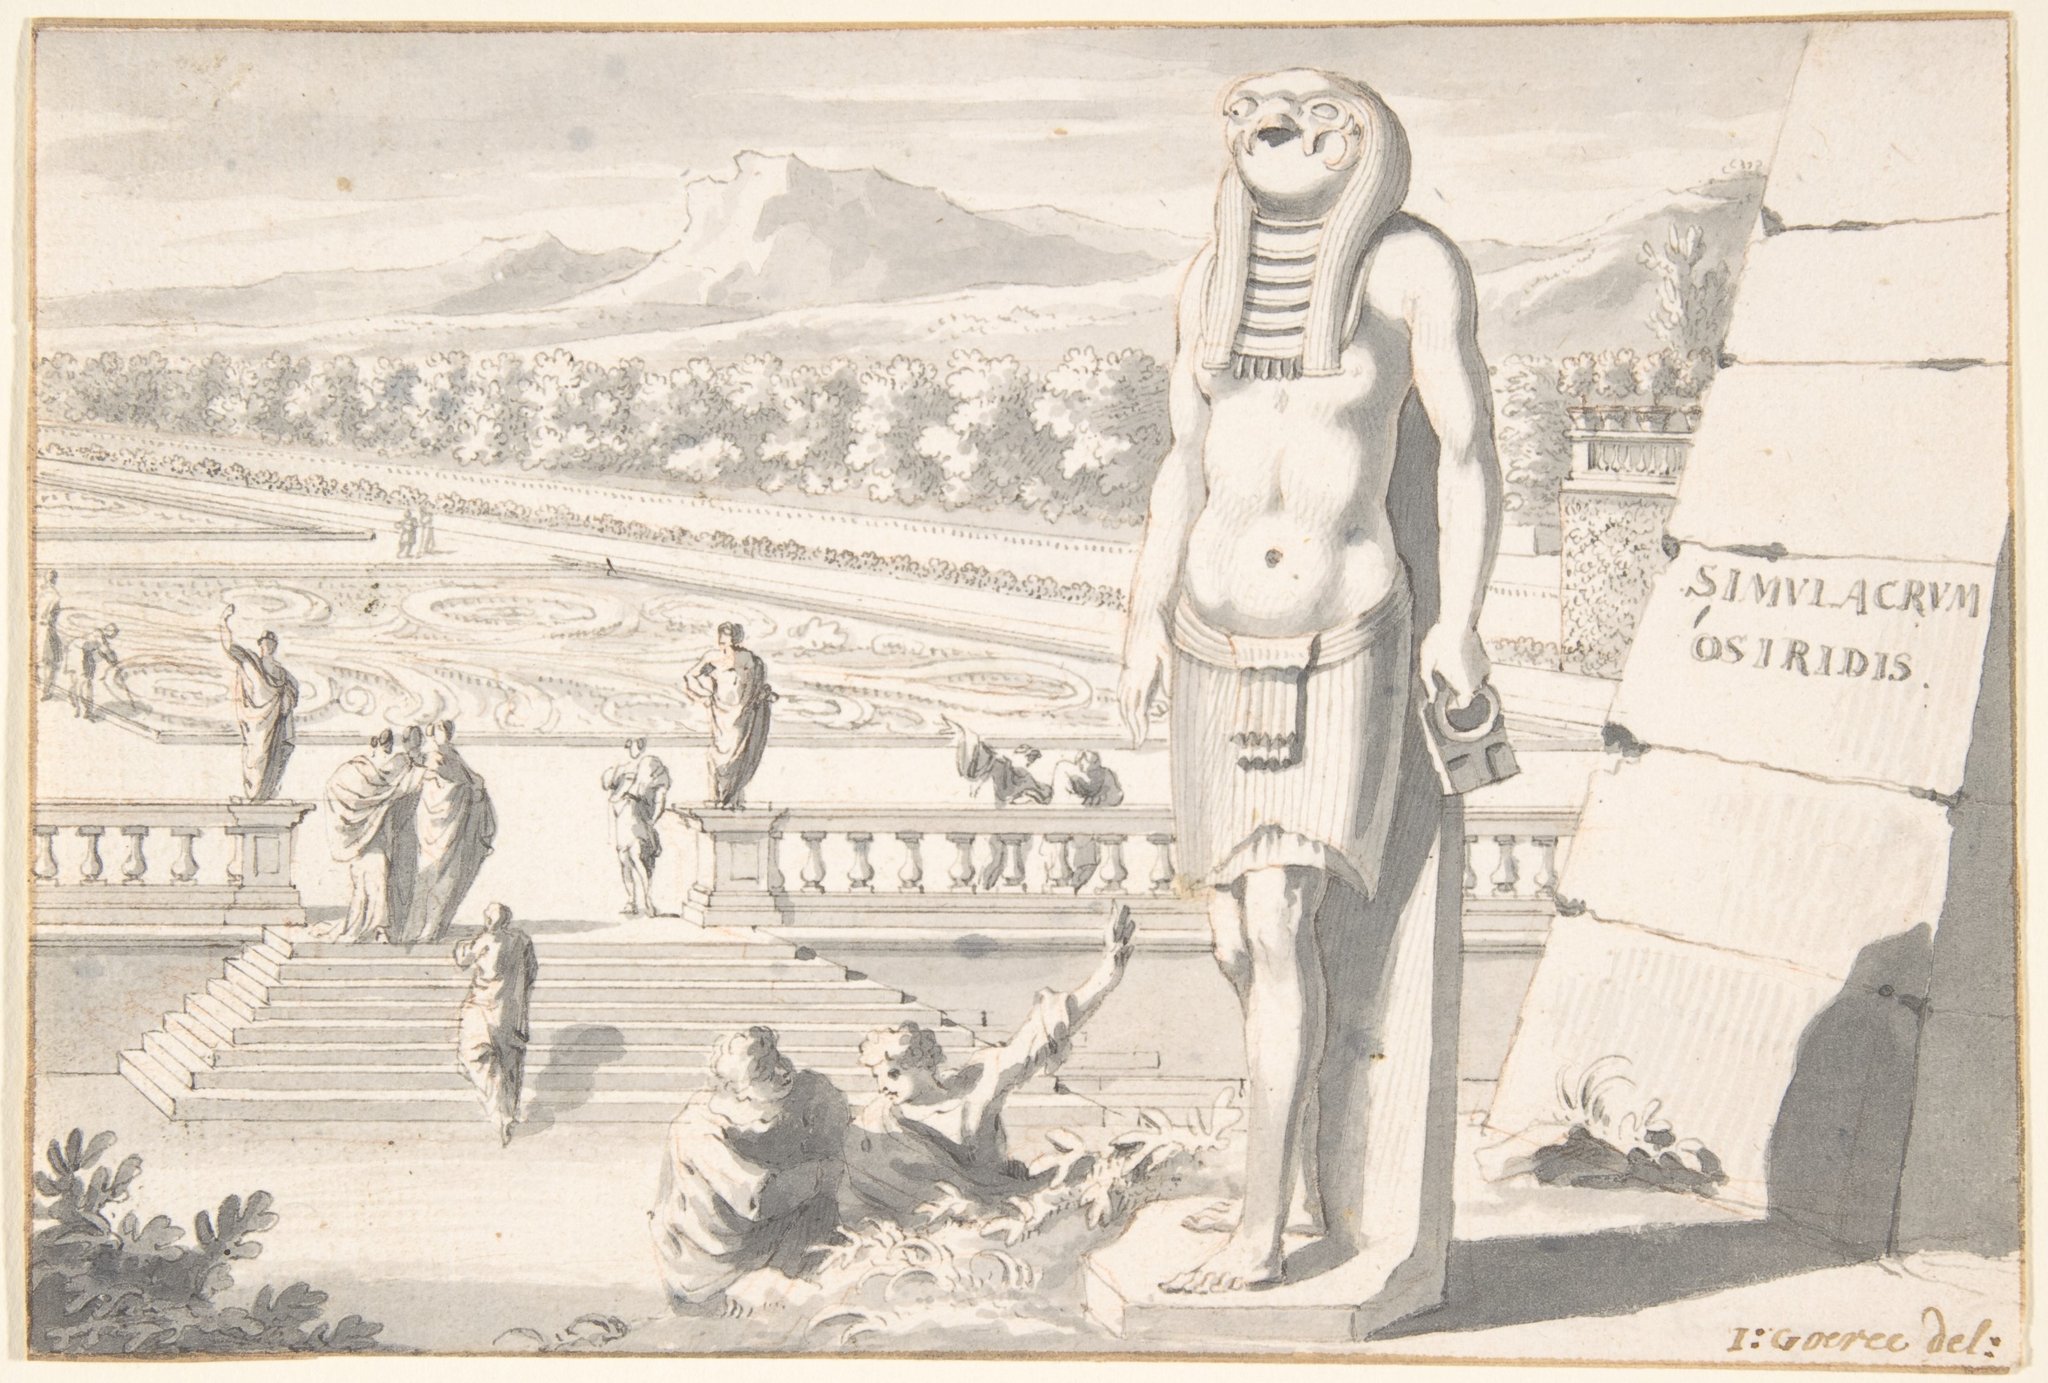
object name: drawing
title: Statue of Osiris in a Garden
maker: jan goeree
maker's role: artist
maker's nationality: dutch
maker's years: 1670-1731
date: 1704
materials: chalk, ink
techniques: brush, pen, wash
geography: italy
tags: gardens,landscapes,osiris